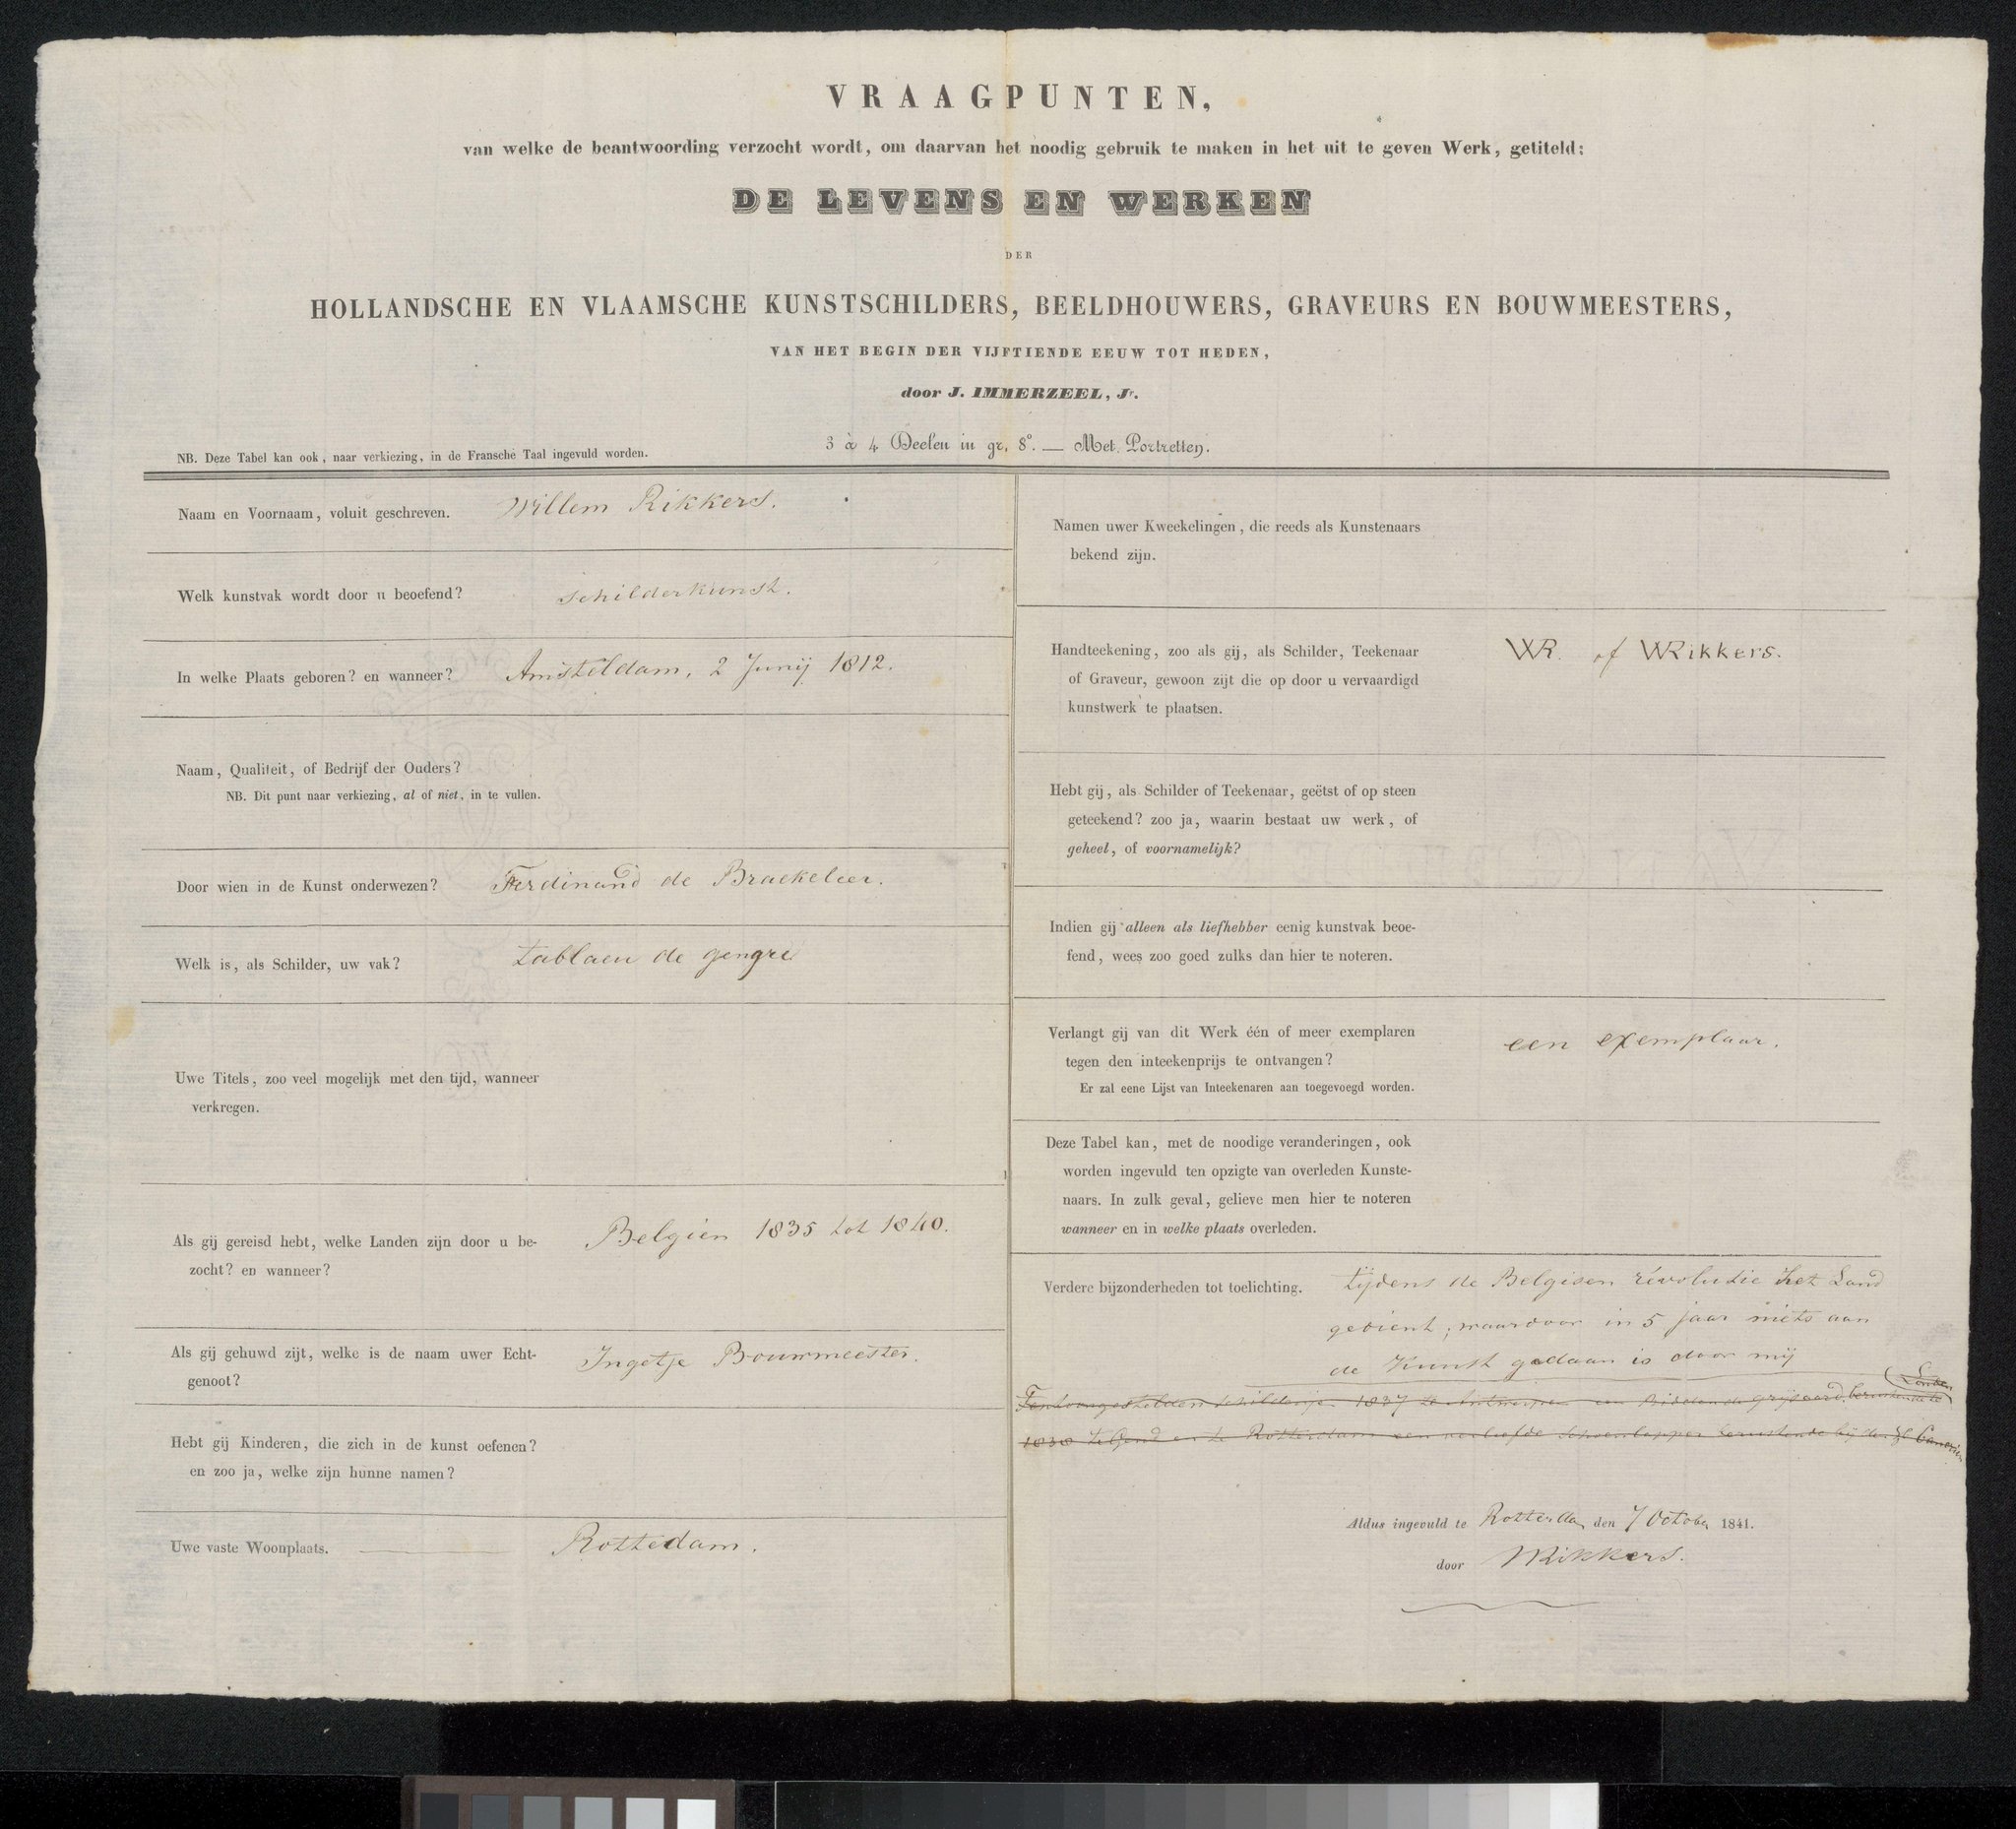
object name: questionnaire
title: Enquêteformulier ingevuld door Willem Rikkers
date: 1841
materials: ink, paper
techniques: pen, printing, writing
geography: rotterdam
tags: rotterdam, painter, print maker, printer, willem rikkers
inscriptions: watermark, inscription: ‘Vraagpunten,/ van welke de beantwoording verzocht wordt, om daarvan het noodig gebruik te maken in het uit te geven Werk, getiteld: De levens en werken/ der Hollandsche en Vlaamsche kunstschilders, beeldhouwers,/ graveurs en bouwmeesters, van het begin der vijftiende eeuw tot heden/ door J. Immerzeel, Jr.’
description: Opgenomen in: Immerzeel, J. Jr., De levens en werken der Hollandsche en Vlaamsche kunstschilders, beeldhouwers, graveurs en bouwmeesters, van het begin der vijftiende eeuw tot heden, Amsterdam: J.C. van Kesteren, 1842-1843.